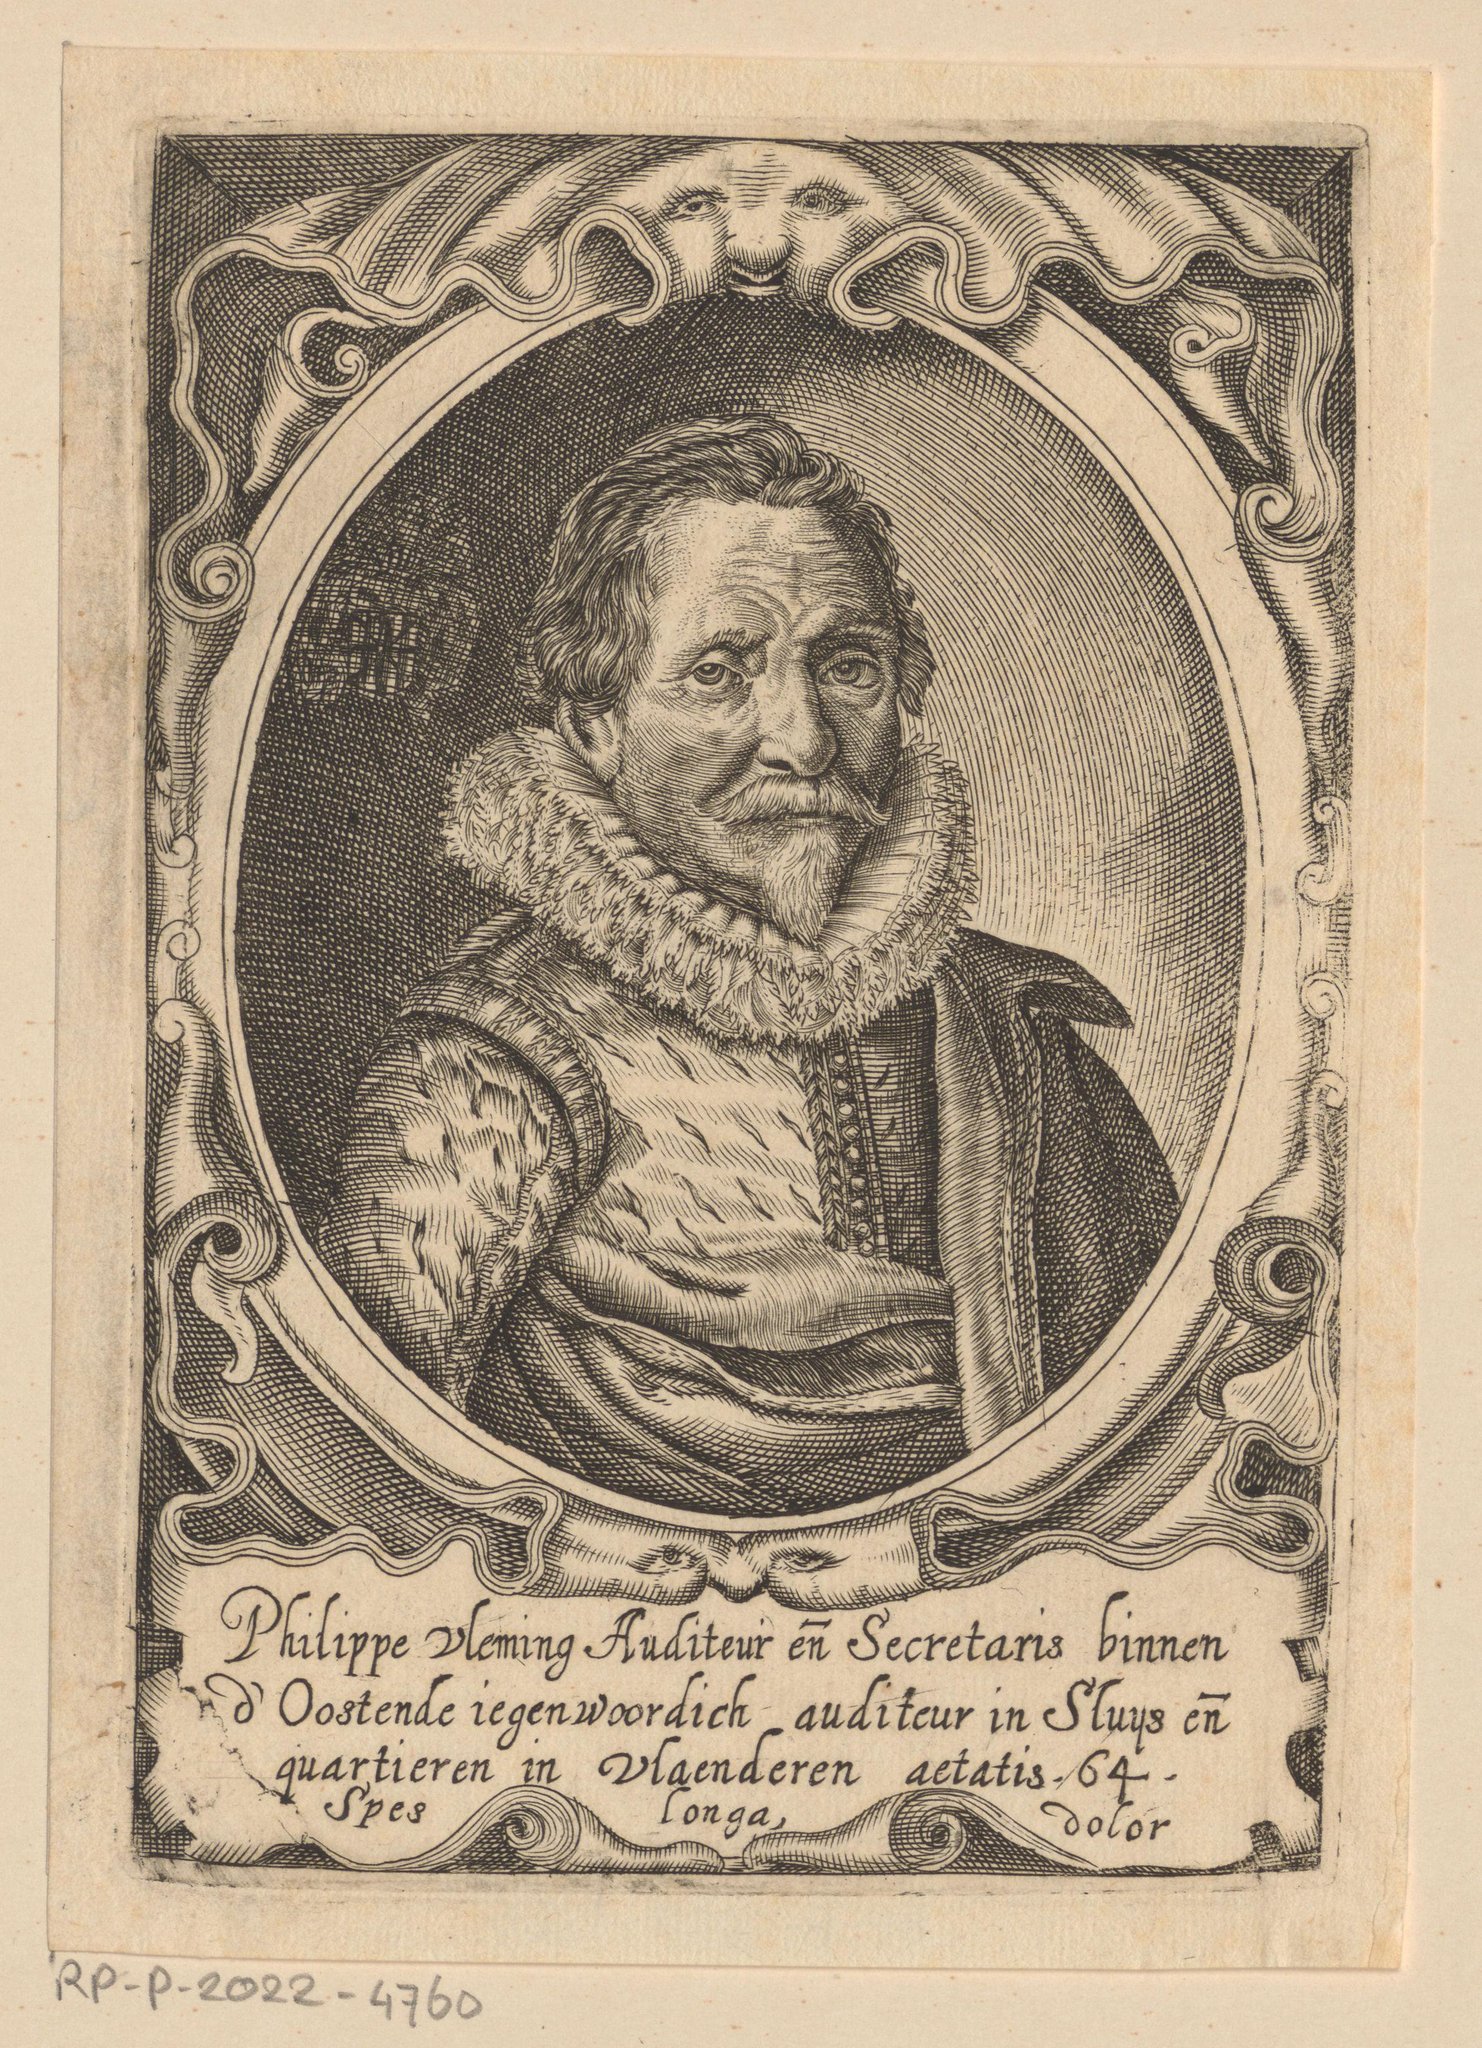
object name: print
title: Portret van Philippe Fleming op 64-jarige leeftijd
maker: Anonymous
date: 1621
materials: paper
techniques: engraving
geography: northern netherlands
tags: official; civil servant; functionary (in general), historical persons, portrait of a writer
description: Prent waarschijnlijk uit: Fleming, Philippe. Oostende. Vermaerde, gheweldighe, lanckduyrighe, ende bloedighe belegheringhe (...). Den Haag: Aert van Meurs, 1621.